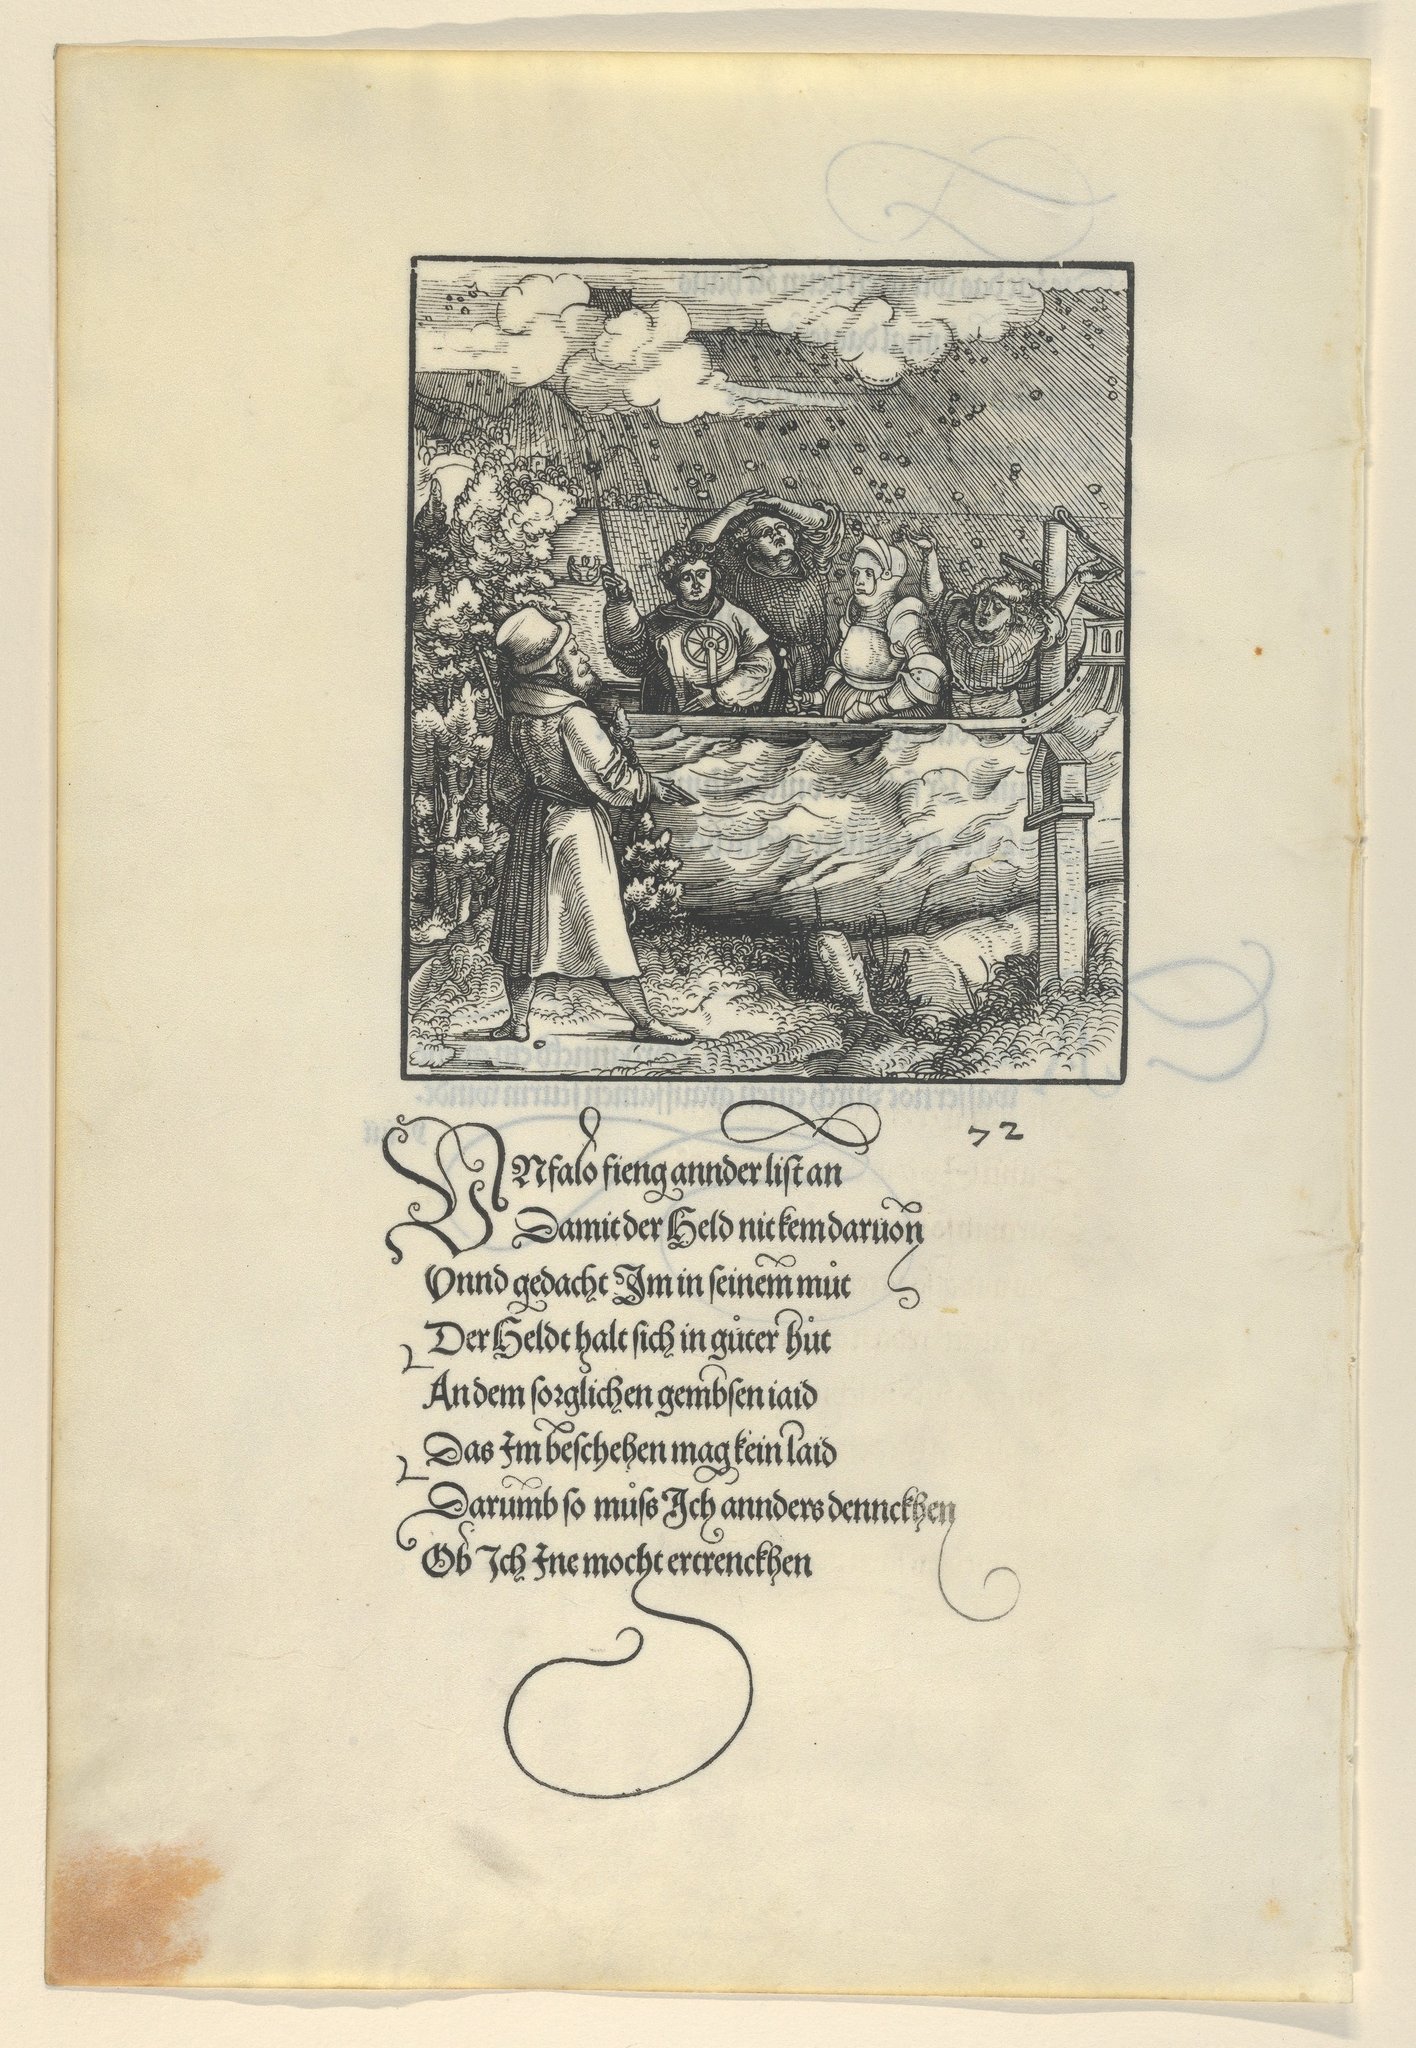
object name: print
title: Theurerdanck's Ship Endangered by Hail and Storm, from Theuerdanck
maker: hans schäufelein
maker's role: artist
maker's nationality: german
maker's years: 1480-1540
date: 1517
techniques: woodcut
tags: men,women,storms,ships